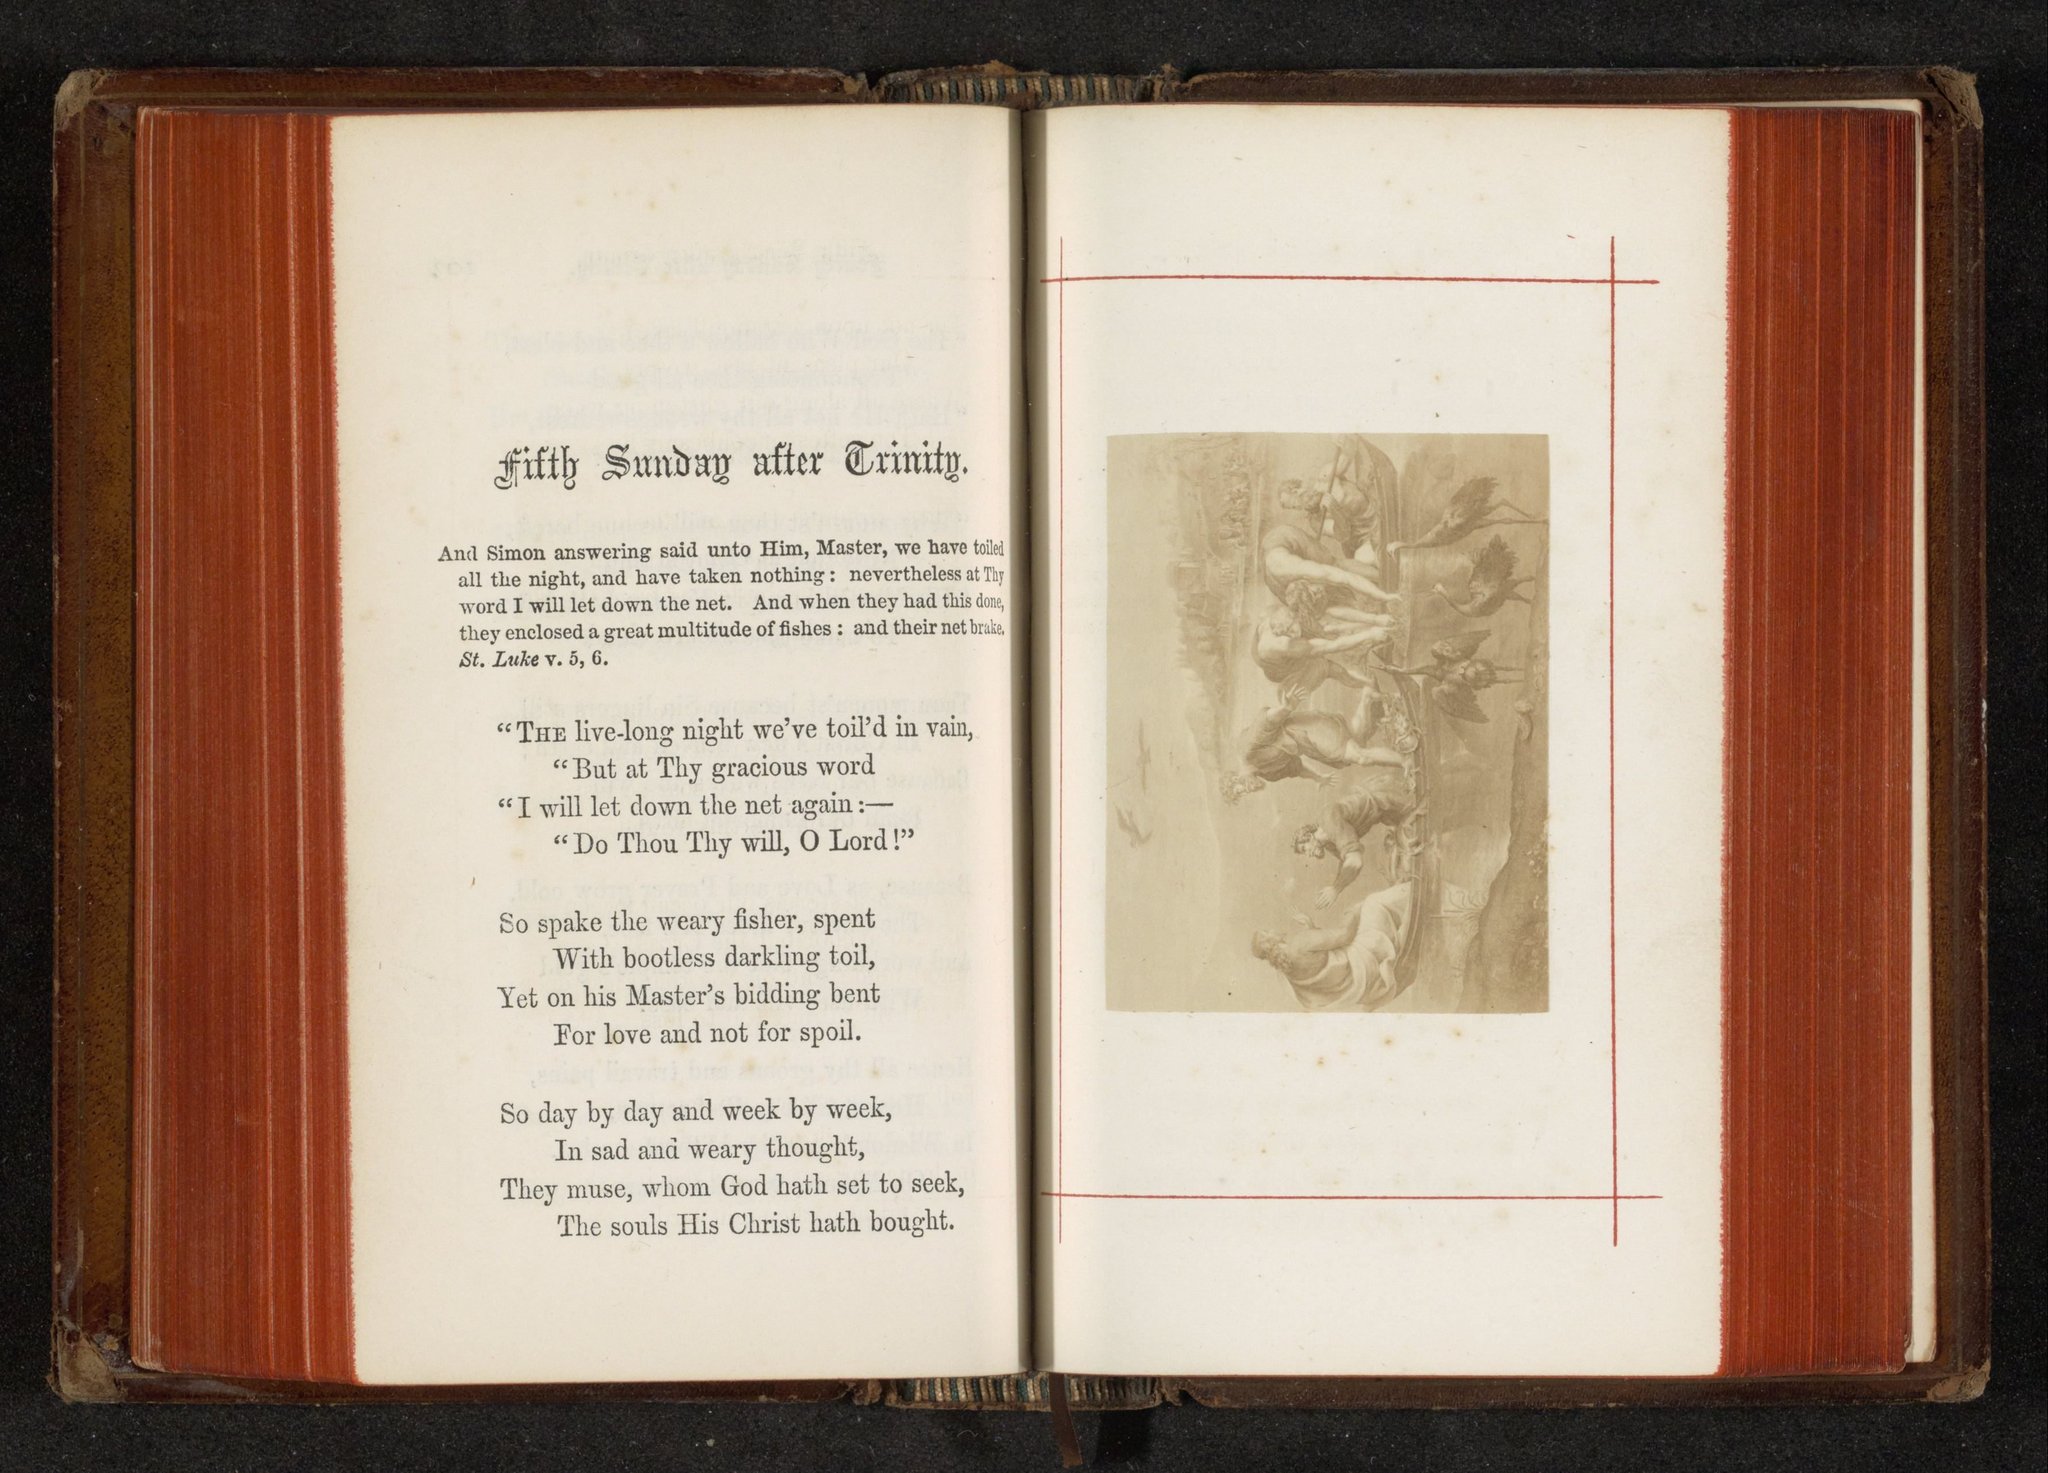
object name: page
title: Fotoreproductie van een prent, voorstellende de wonderbaarlijke visvangst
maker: Anonymous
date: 1865-1870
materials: photographic support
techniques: albumen print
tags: appearance of christ at the lake of gennesaret (sea of galilee, sea of tiberias): miraculous draught of fishes (after the resurrection)